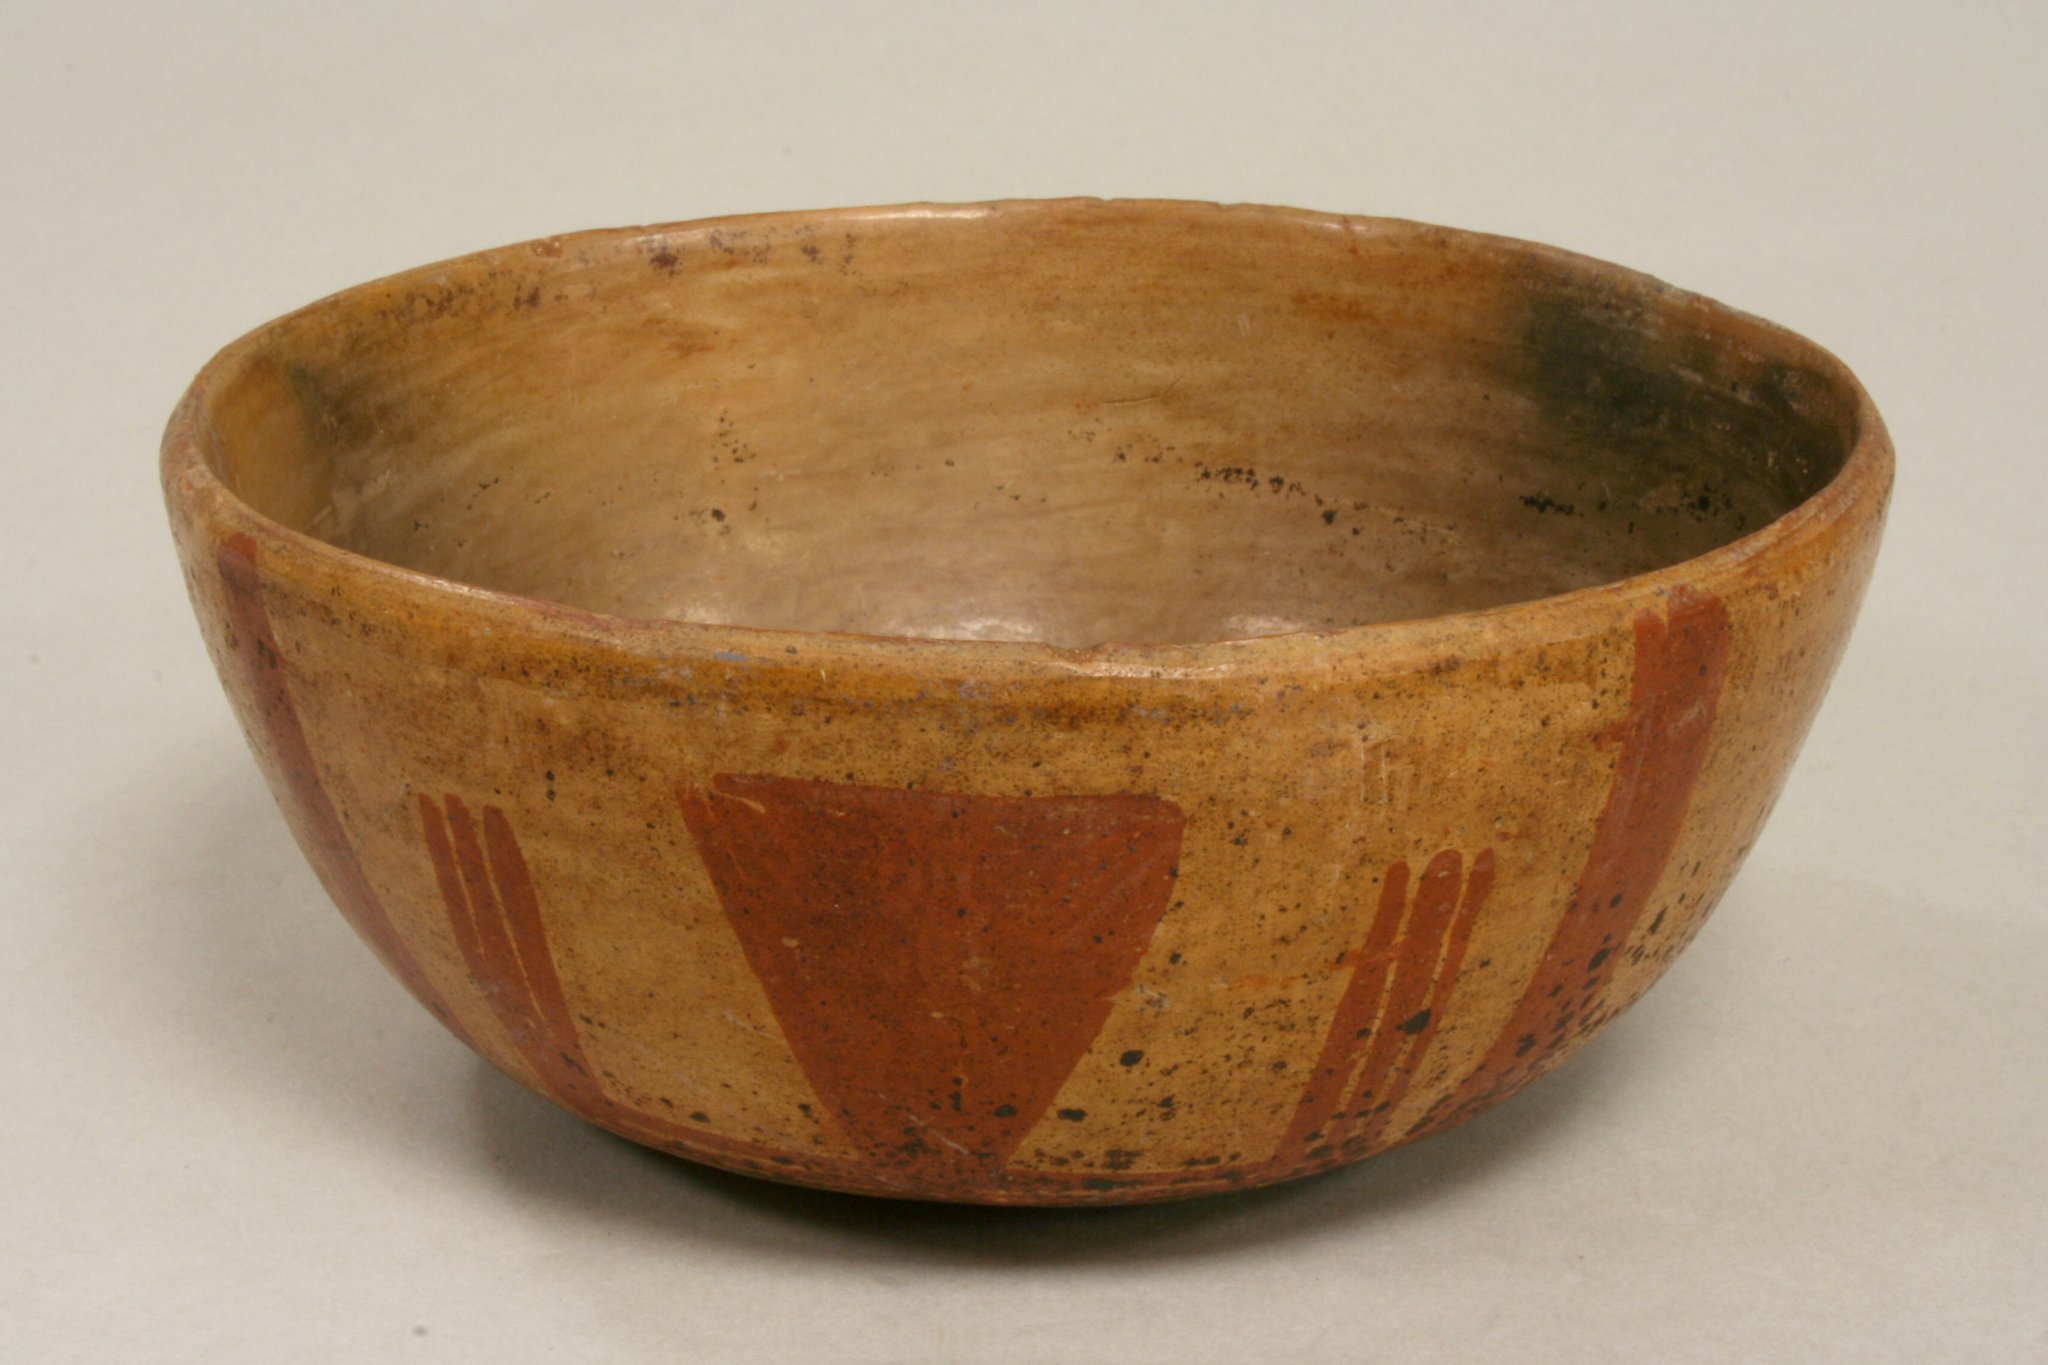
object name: bowl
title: Painted Bowl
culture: michoacán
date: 101-600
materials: ceramic, pigment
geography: mexico